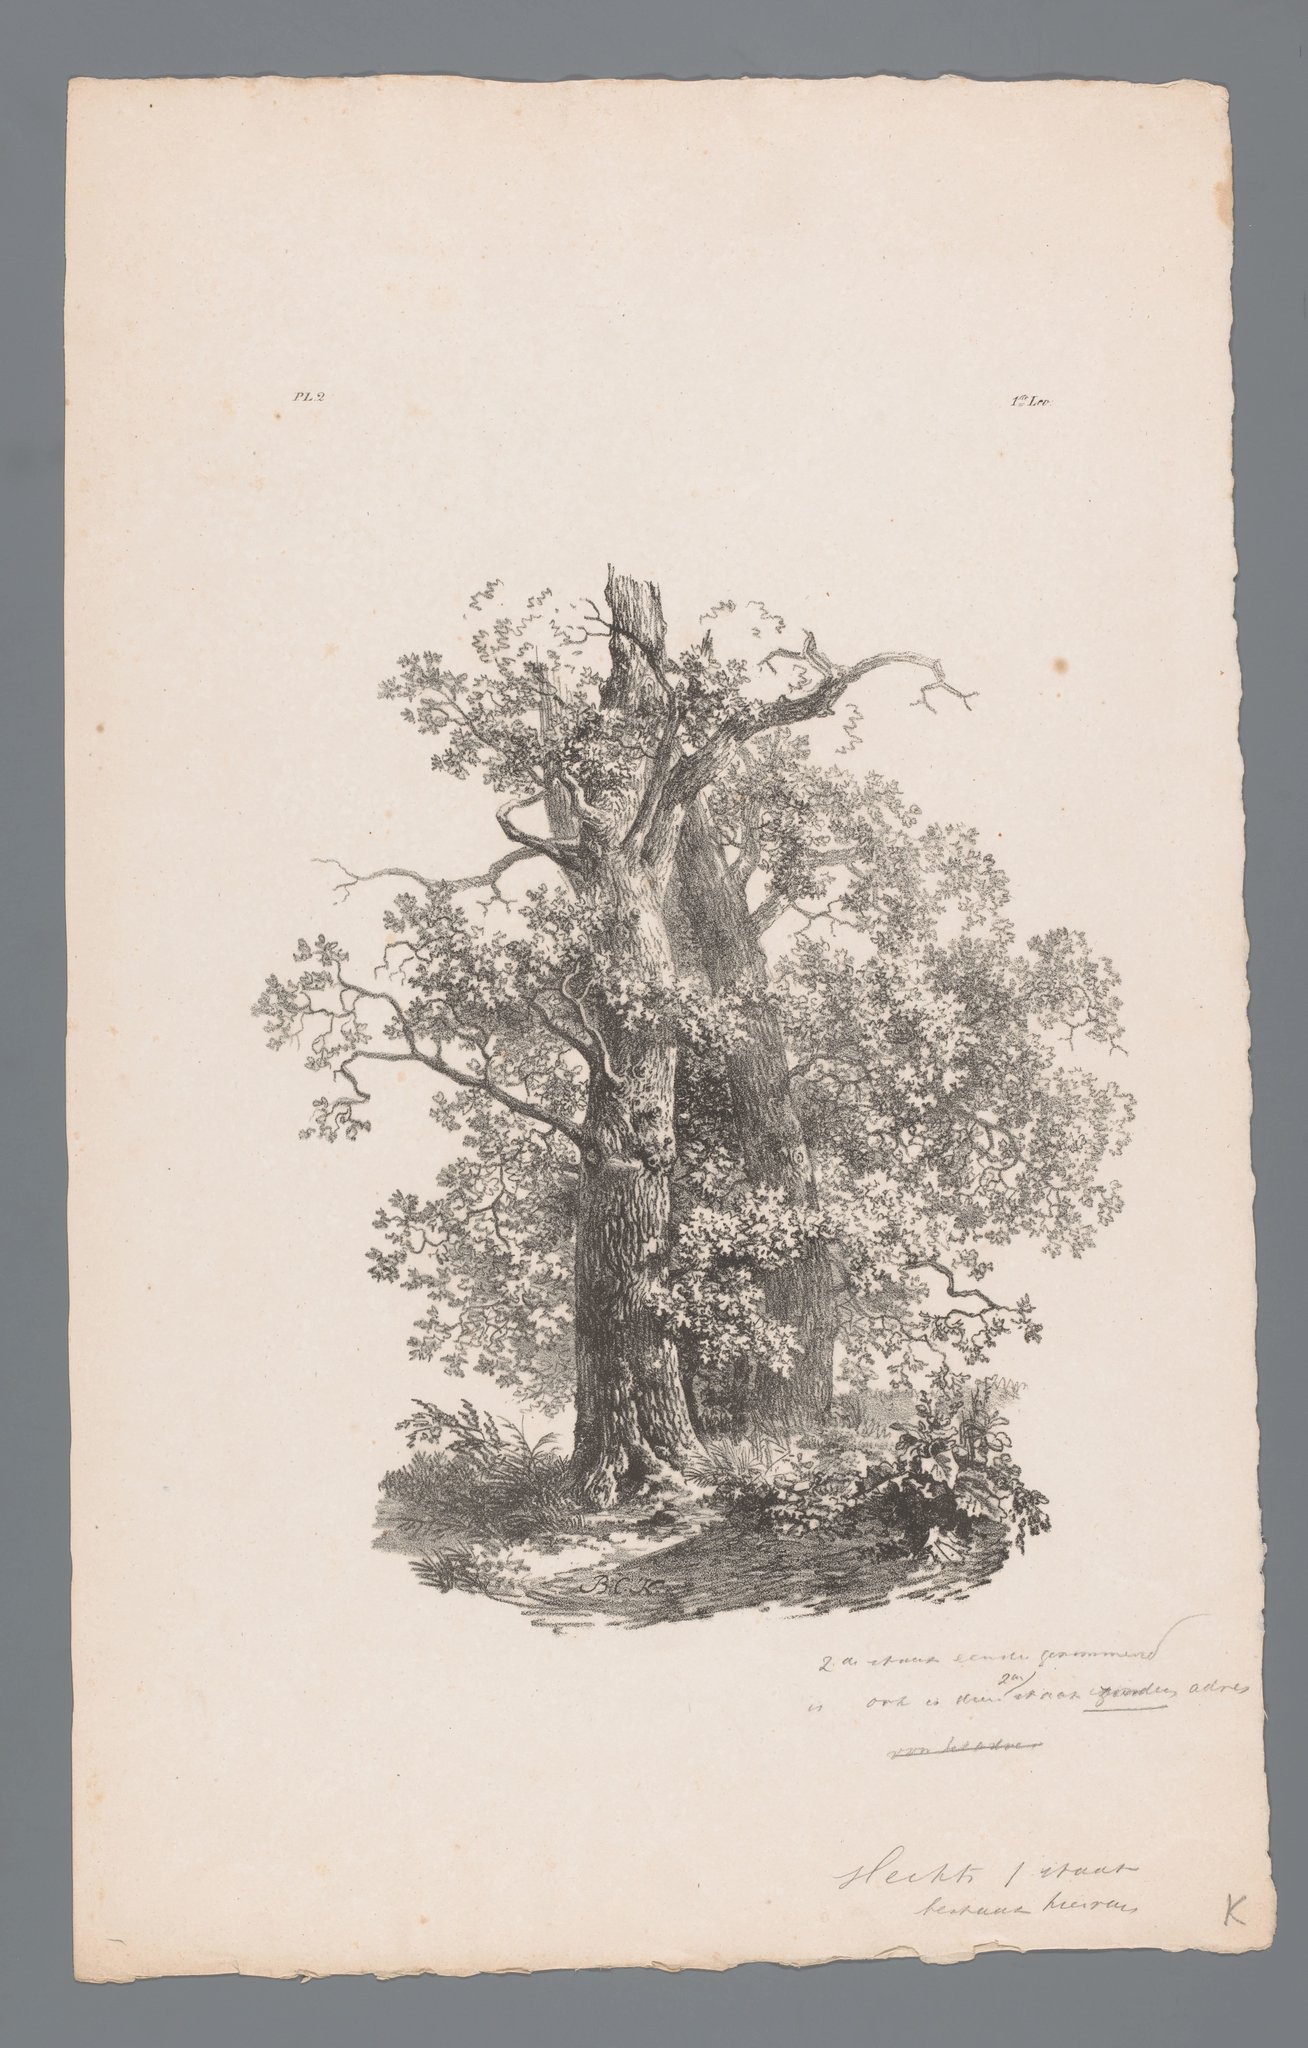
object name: print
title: Landschap studiën eerste levering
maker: barend cornelis koekkoek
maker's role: draughtsman, painter, print maker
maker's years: 1803-1862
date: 1829-1845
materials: paper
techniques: lithograph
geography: amsterdam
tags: groups of trees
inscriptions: collector's mark: Lugt 2228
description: In 1829 en 1830 gaf Koekkoek, samen met Daiwaille, zes cahiers uit met ieder zes prenten getiteld Landschapstudiën. Deze werden gebruikt in het tekenonderwijs. Vijftien jaar later werd deze reeks, in een andere samenstelling nogmaals uitgegeven door Meyer en Comp in Amsterdam. Zie: De Bruyn Kops, 1963.